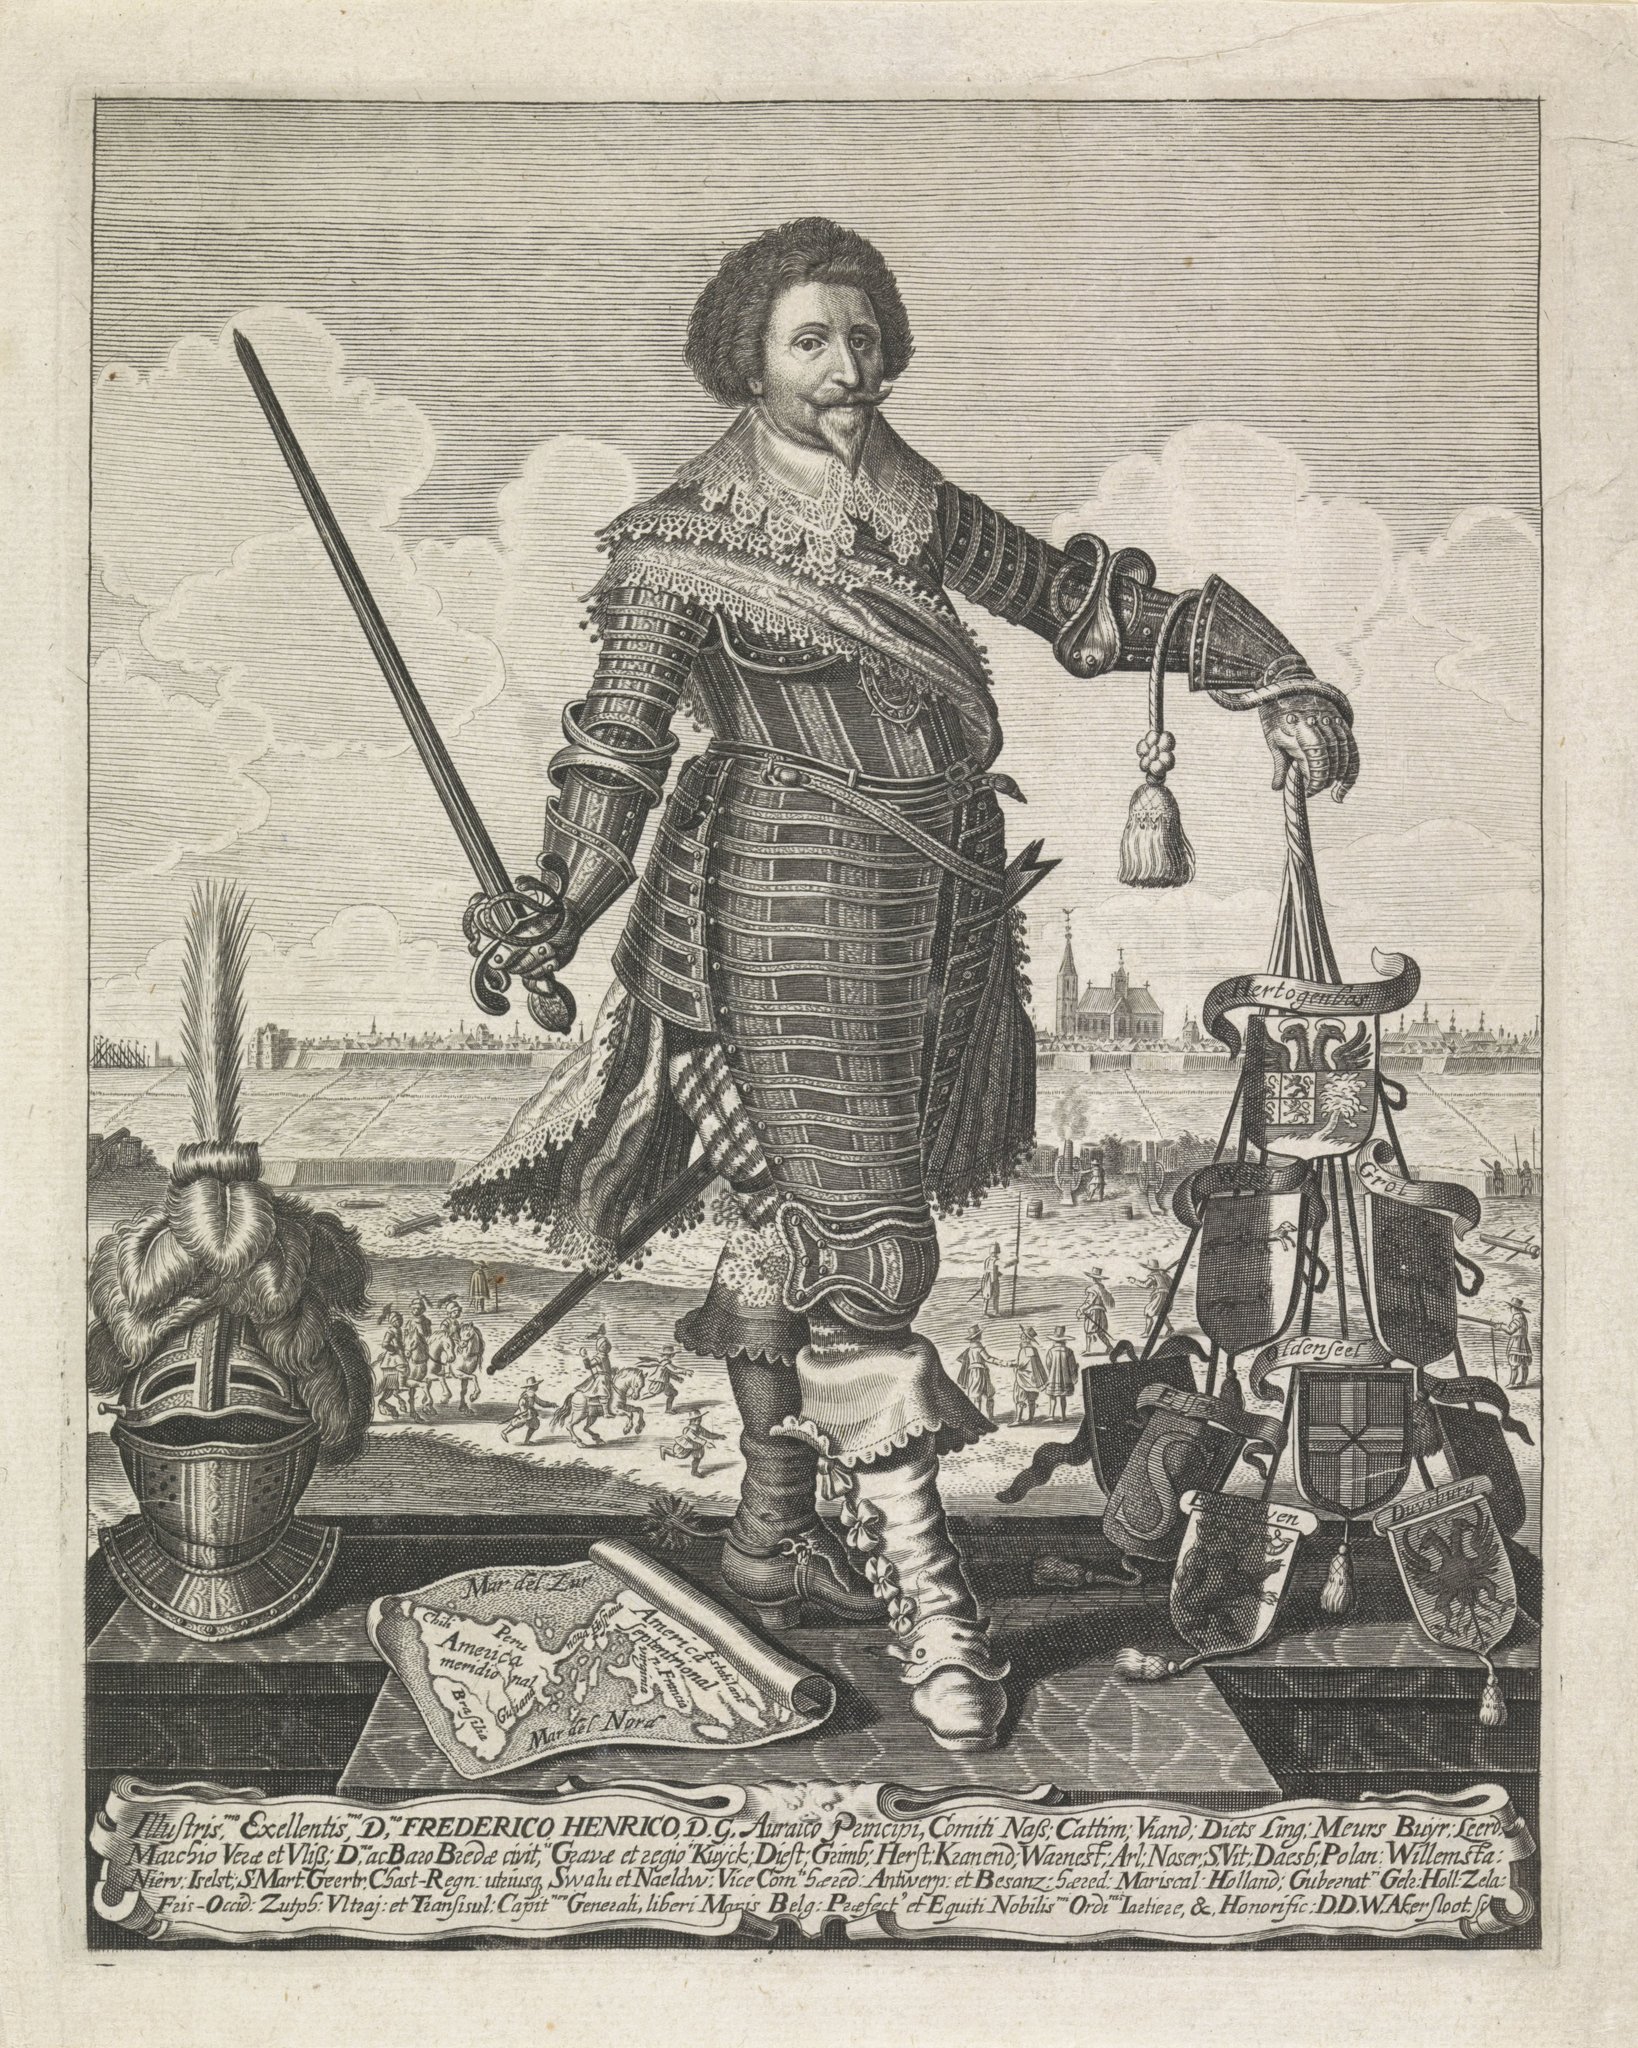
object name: print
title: Portret van Frederik Hendrik, prins van Oranje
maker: willem outgertsz. akersloot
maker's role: print maker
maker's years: 1600-1651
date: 1629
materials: paper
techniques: engraving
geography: the hague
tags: delft, frederick henry (prince of orange)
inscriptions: collector's mark: Lugt 2228, collector's mark: Lugt 963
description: Portret van Frederik Hendrik, ten voeten uit in wapenrusting, staande op een bordes. In zijn rechterhand een degen, in zijn linker een touw. Aan het touw zijn de wapens van onder andere Den Bosch en Groenlo vastgemaakt. Op de achtergrond het Beleg van Den Bosch, 1929. In een cartouche vier regels Latijnse tekst.